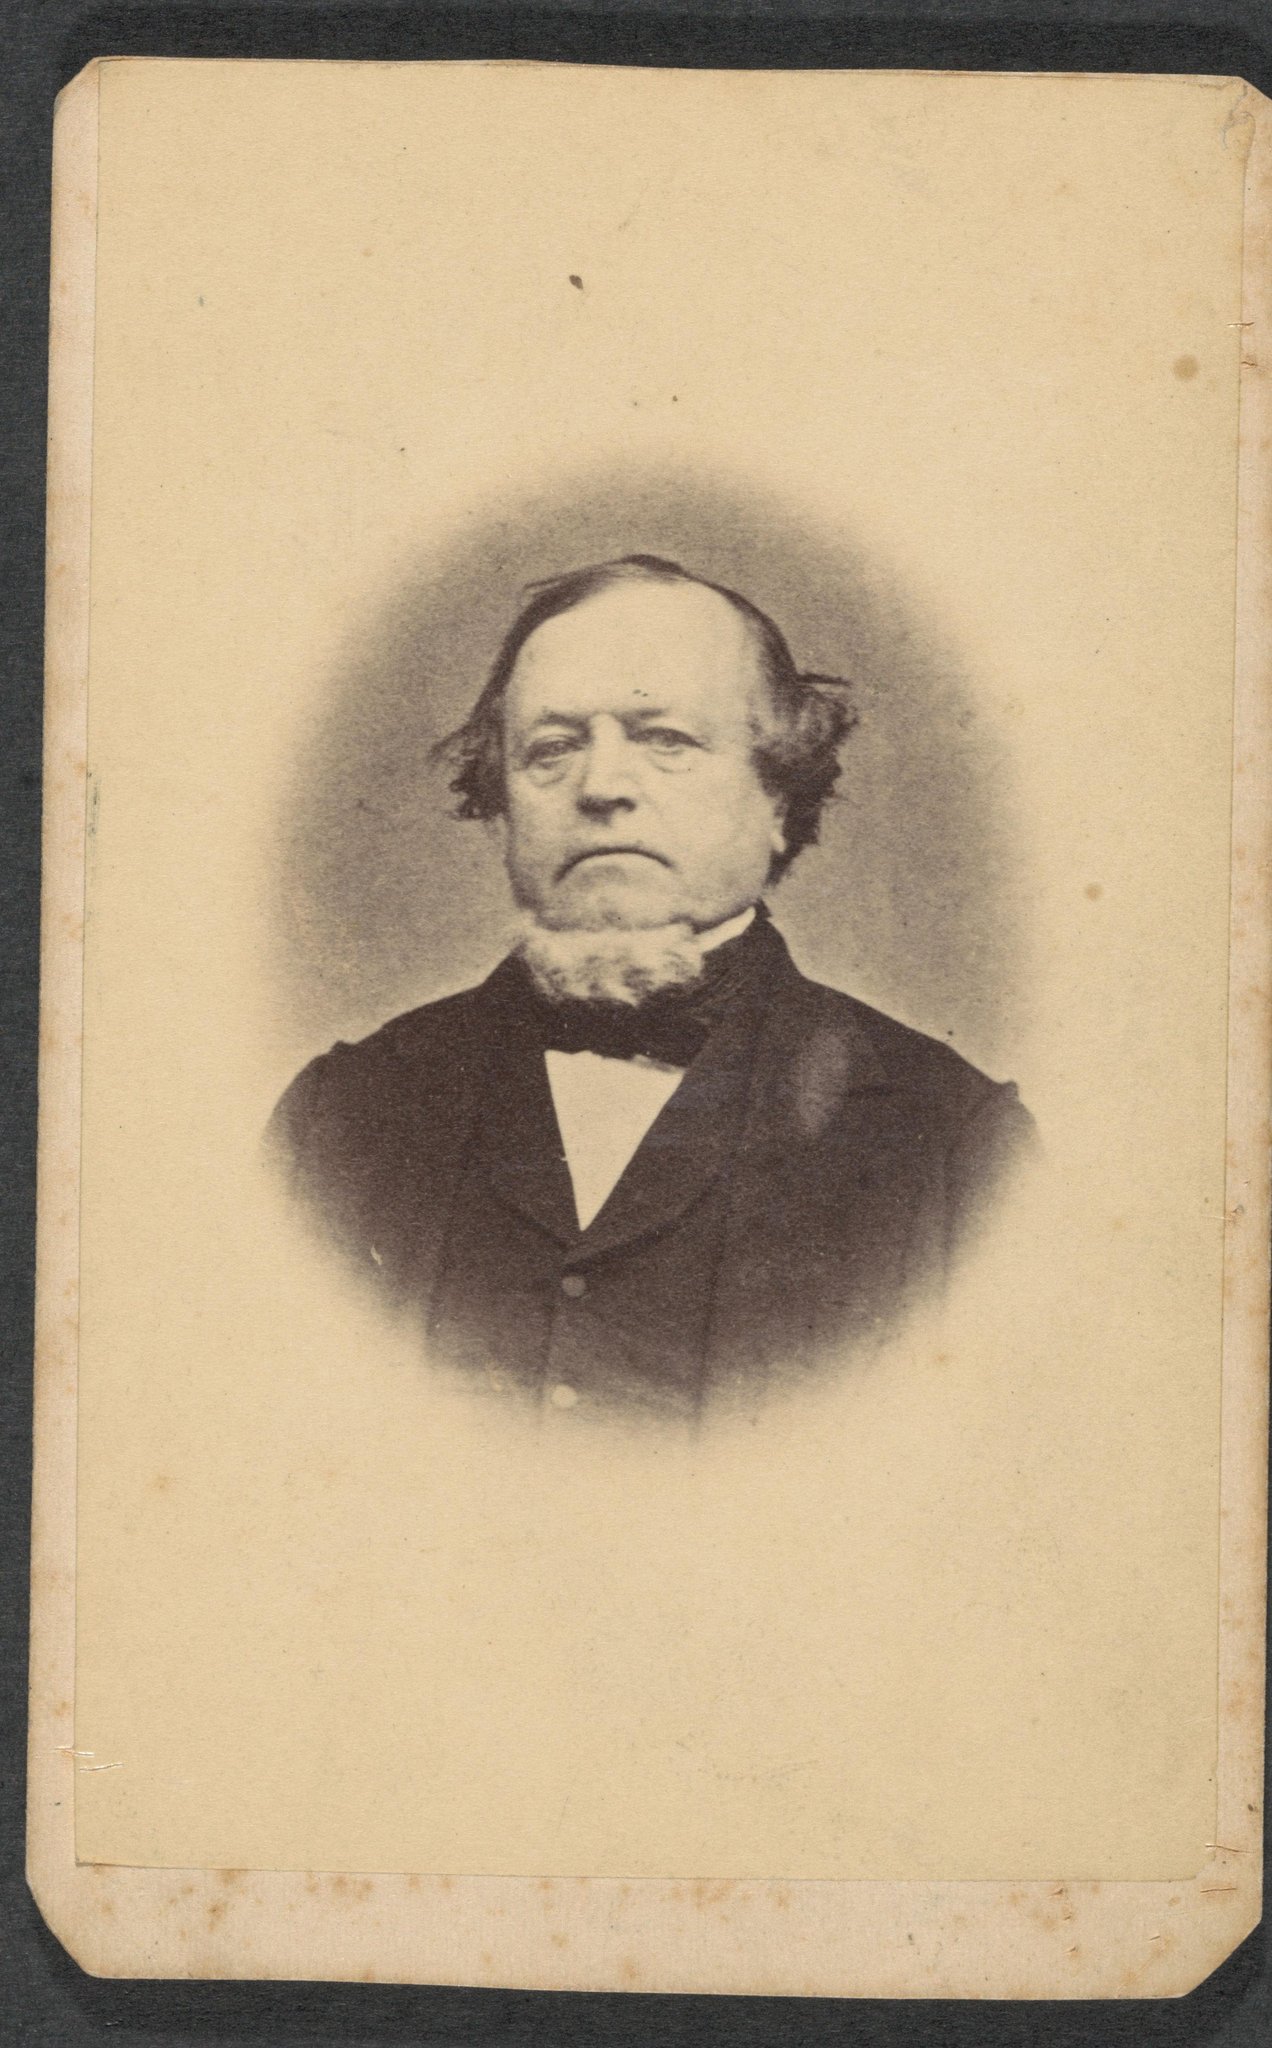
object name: carte de visite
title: Portret van een onbekende man uit de familie Marmelstein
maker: Anonymous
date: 1850-1900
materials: cardboard, photographic support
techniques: albumen print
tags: historical persons not known by name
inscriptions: annotation: ‘Van Fr F’, annotation: ‘Th. M. Scato Trip.’, annotation: ‘Opa’